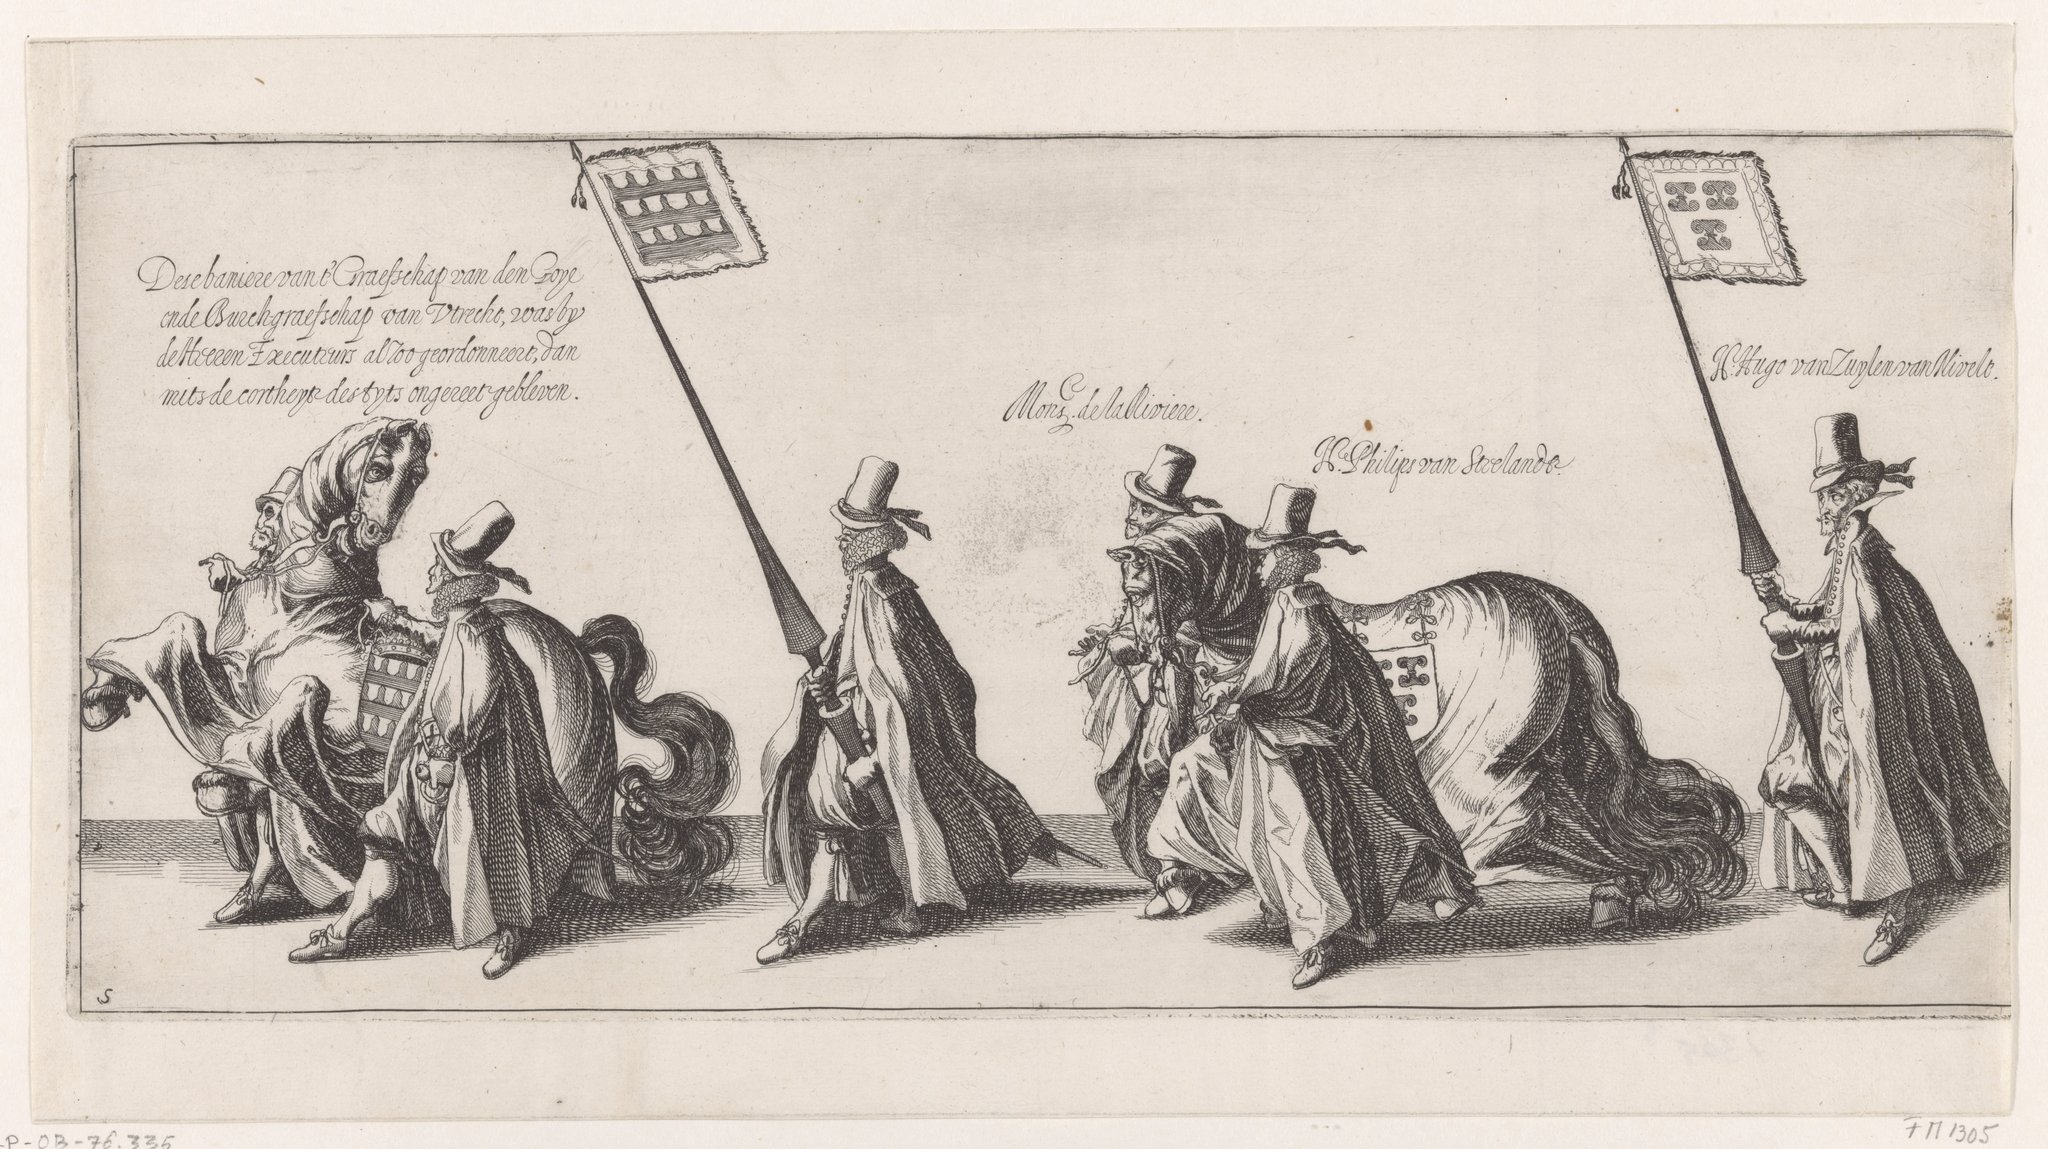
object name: print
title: De begrafenisstoet (plaat 5), 1615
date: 1615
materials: paper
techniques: etching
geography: northern netherlands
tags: cortege, funeral procession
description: De begrafenisstoet (plaat 5). Twee paarden en twee banieren. Onderdeel van de serie prenten van de begrafenisoptocht van Walraven van Brederode, heer van Vianen, op 29 januari 1615 te Vianen.